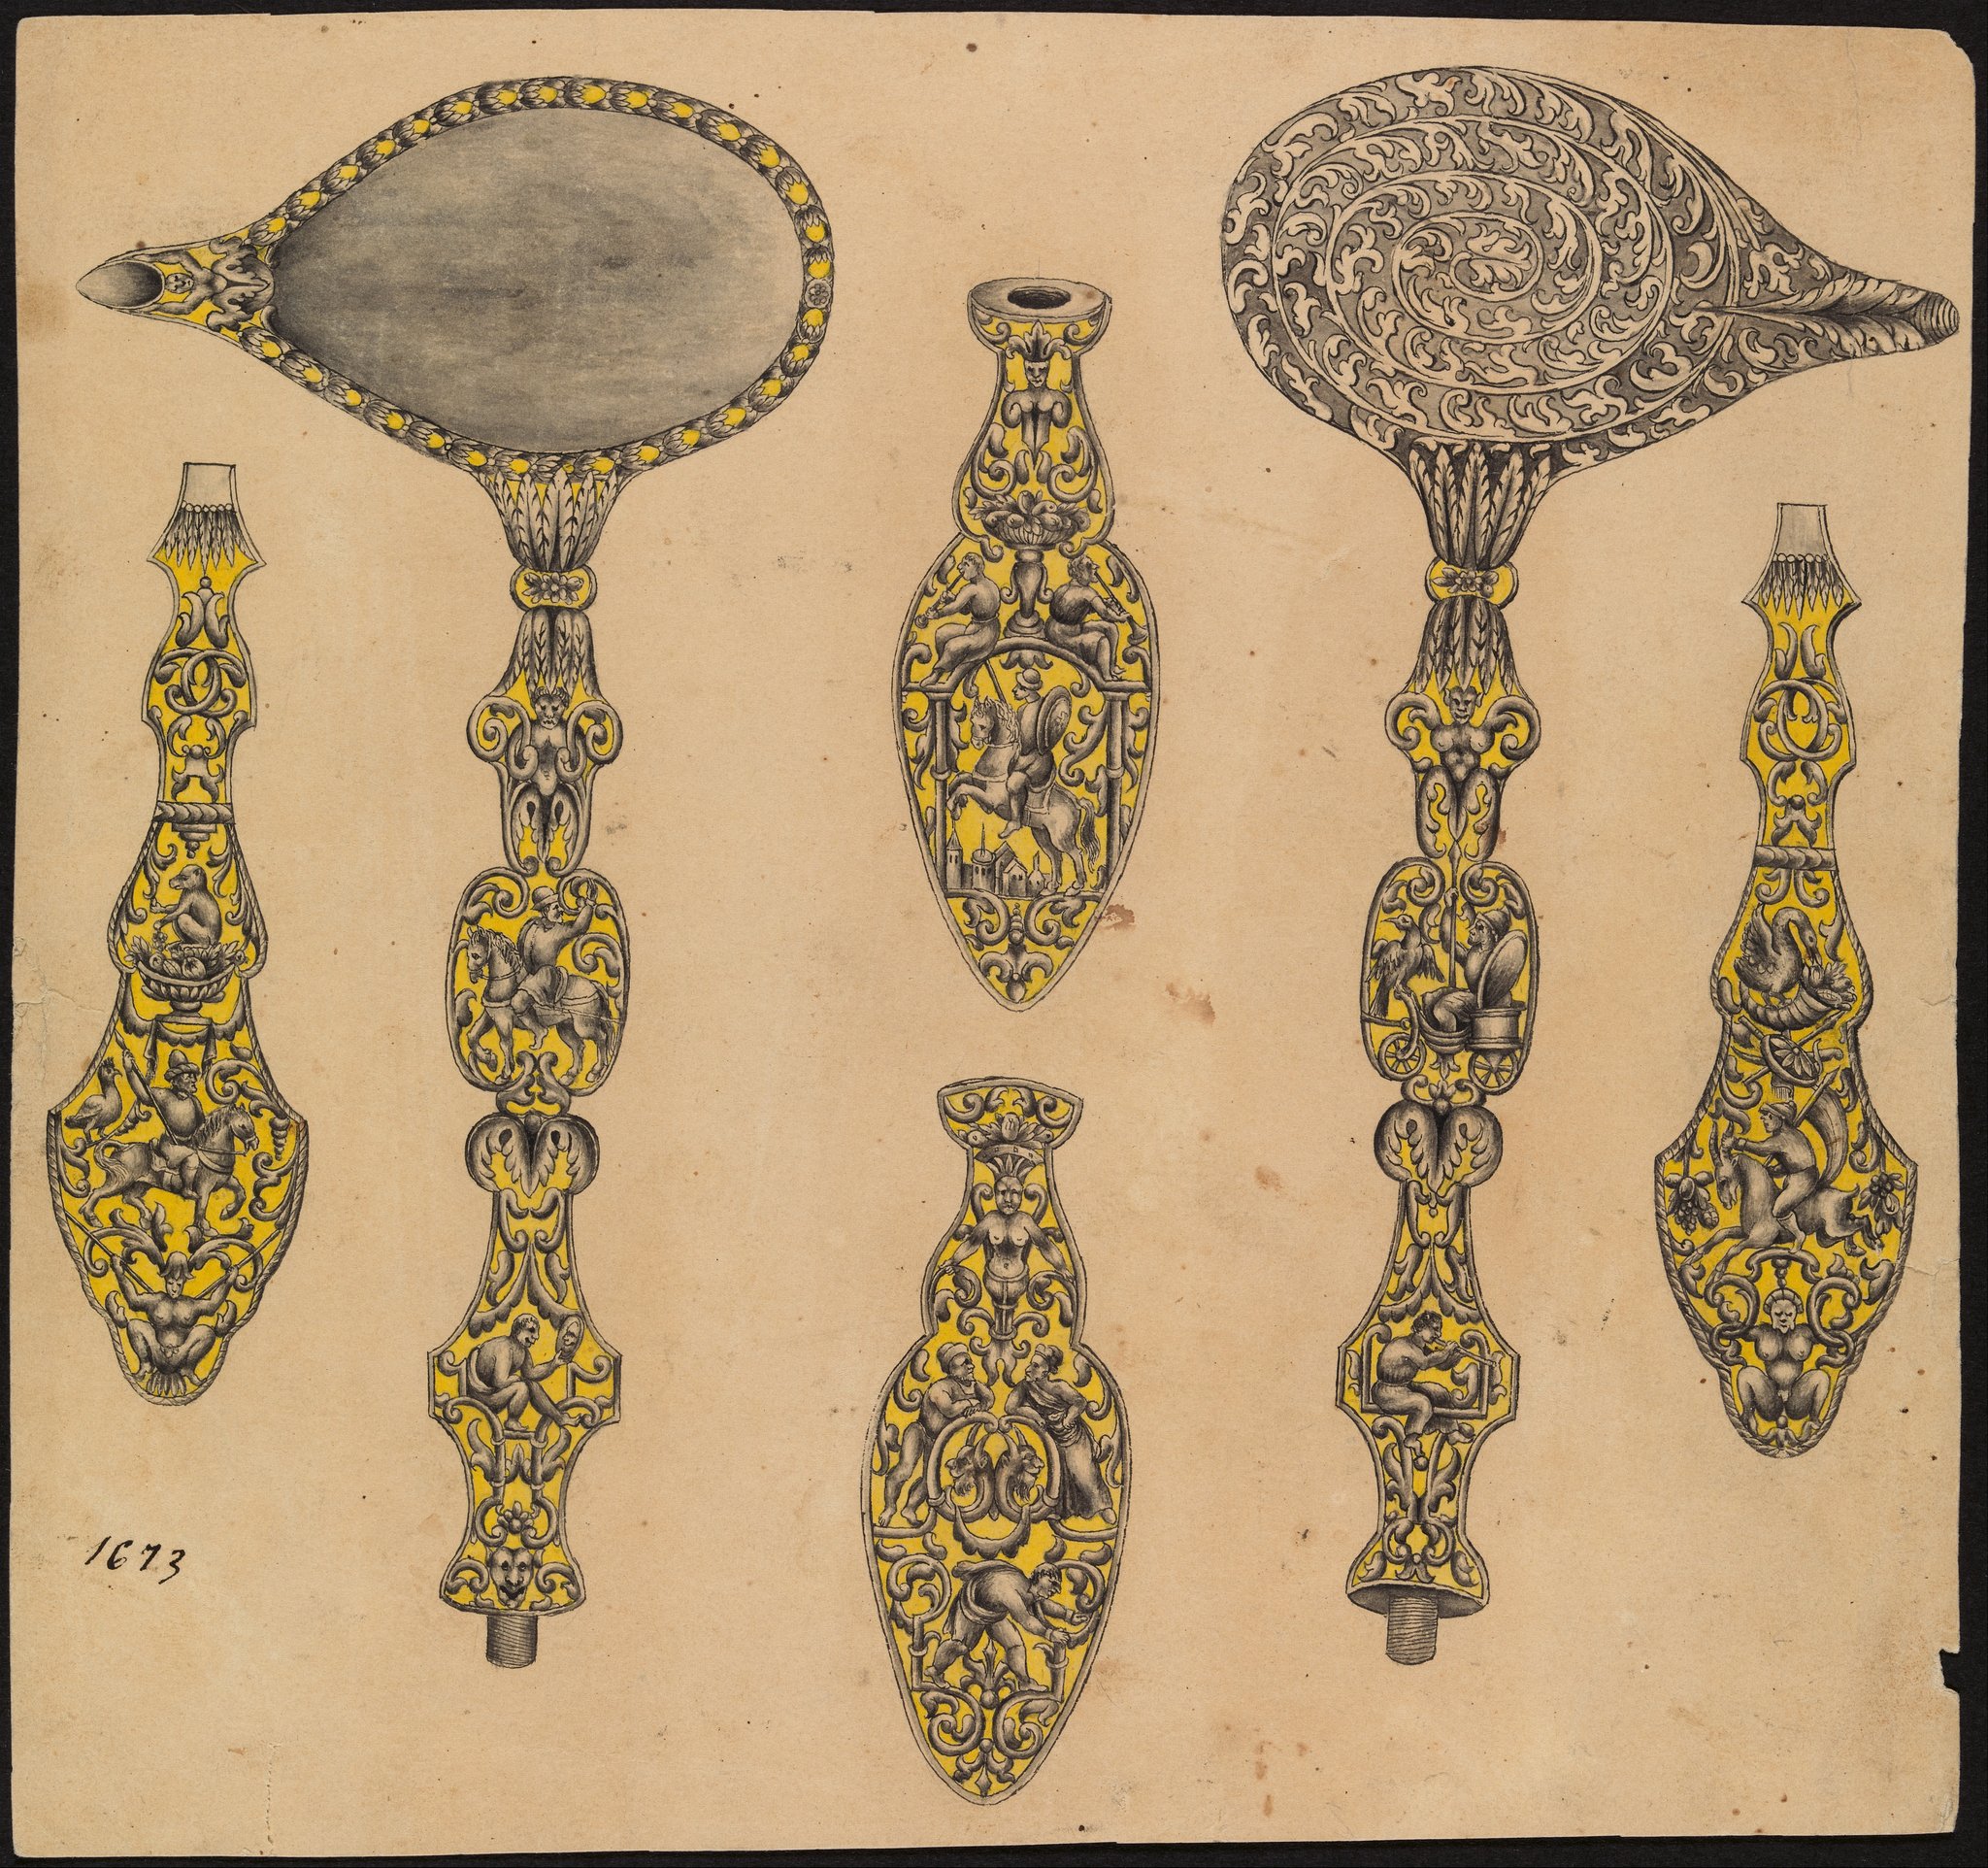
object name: drawing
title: Design for the Decoration of Two Firearms Accessories, a Ladle and a Screwdriver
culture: spanish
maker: eusebio zuloaga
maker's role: designer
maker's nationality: spanish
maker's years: 1808-1898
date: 1850-1851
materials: ink, paper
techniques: pen, wash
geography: spain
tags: ornament